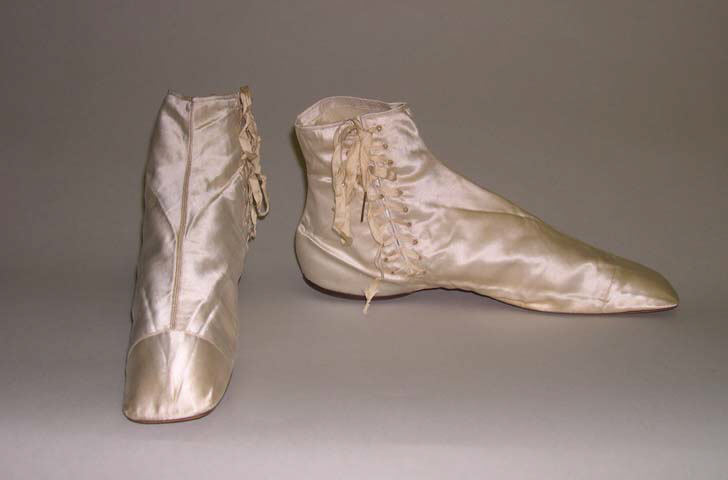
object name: boot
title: Boots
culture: french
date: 1830-1839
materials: leather, silk